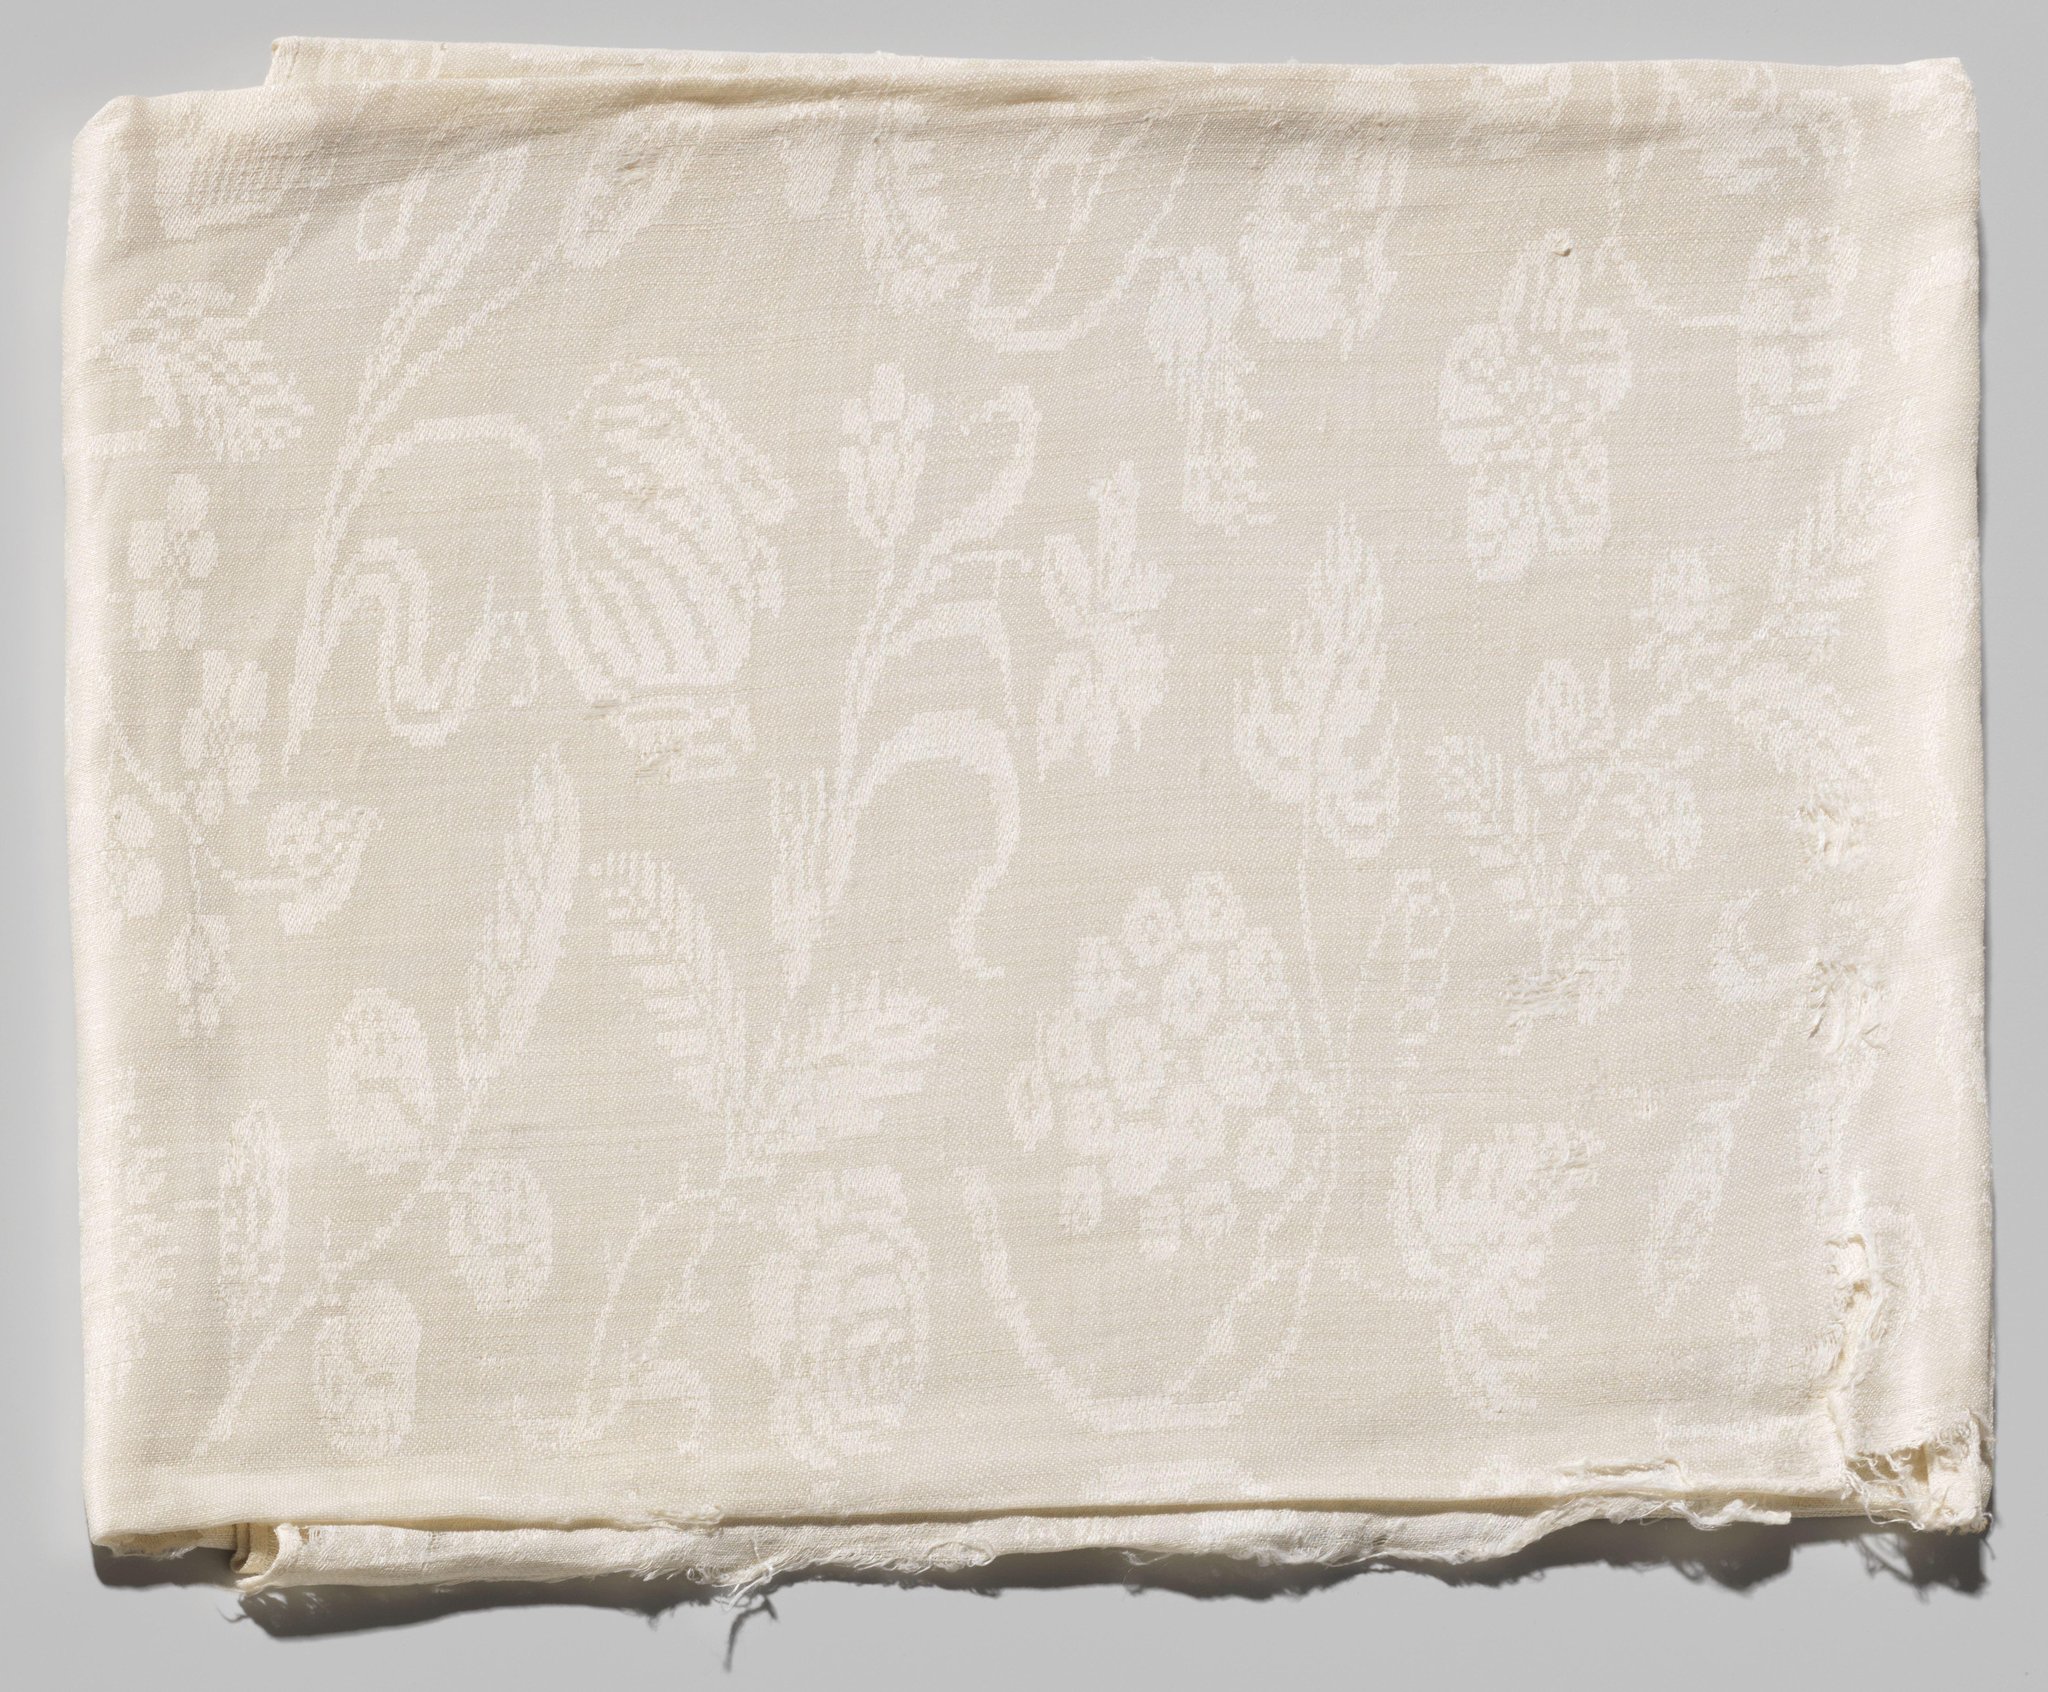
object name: napkin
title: Servet met bloeiende- en vruchtdragende stengels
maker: Anonymous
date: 1675-1700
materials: linen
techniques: damask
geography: netherlands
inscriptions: mark: ‘WVV 6’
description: Servet van linnendamast met bloeiende- en vruchtdragende stengels. Middenveld: Symmetrisch, driemaal herhaald patroon, met druiventros, granaatappel, aardbei, anemoon, anjer, peer, pruim, tulp, eikel, roos en narcis. Brede randen met symmetrische ruggelings verdubbelde vaasvorm van acanthusbladeren waaruit gevariëerd bloemboequet ontspruit. Hoeken: een rozet. Rondom: blokkenrand.